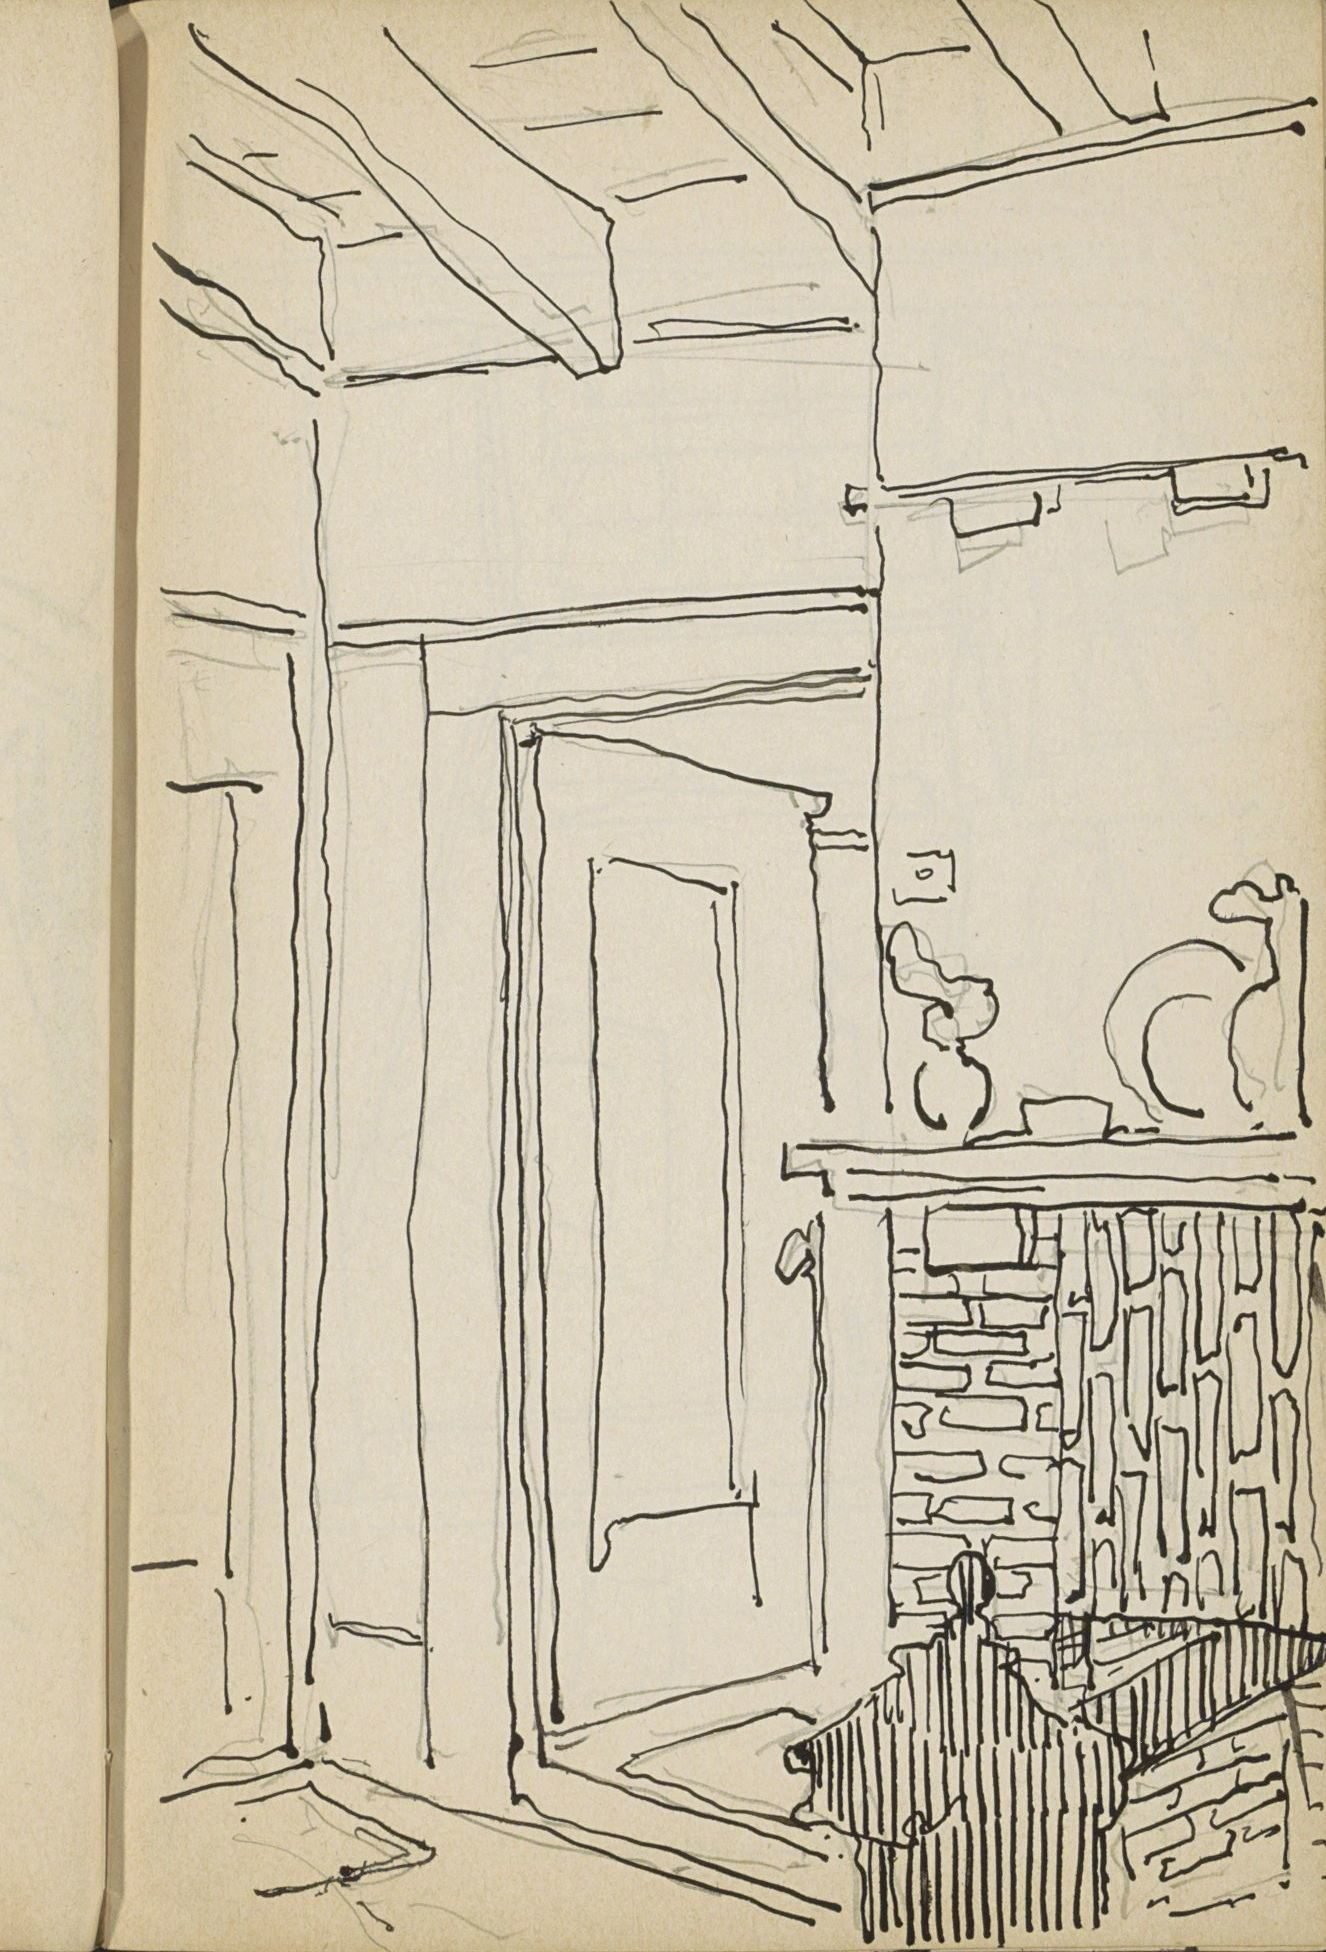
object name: sketchbook leaf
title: Deur naast een schoorsteenmantel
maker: reijer stolk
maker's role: draughtsman, print maker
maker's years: 1896-1945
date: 1908-1919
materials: ink, paper, pencil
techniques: pen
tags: interior of the house, chimney-piece, mantelpiece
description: Blad 27 recto uit een schetsboek met 33 bladen.